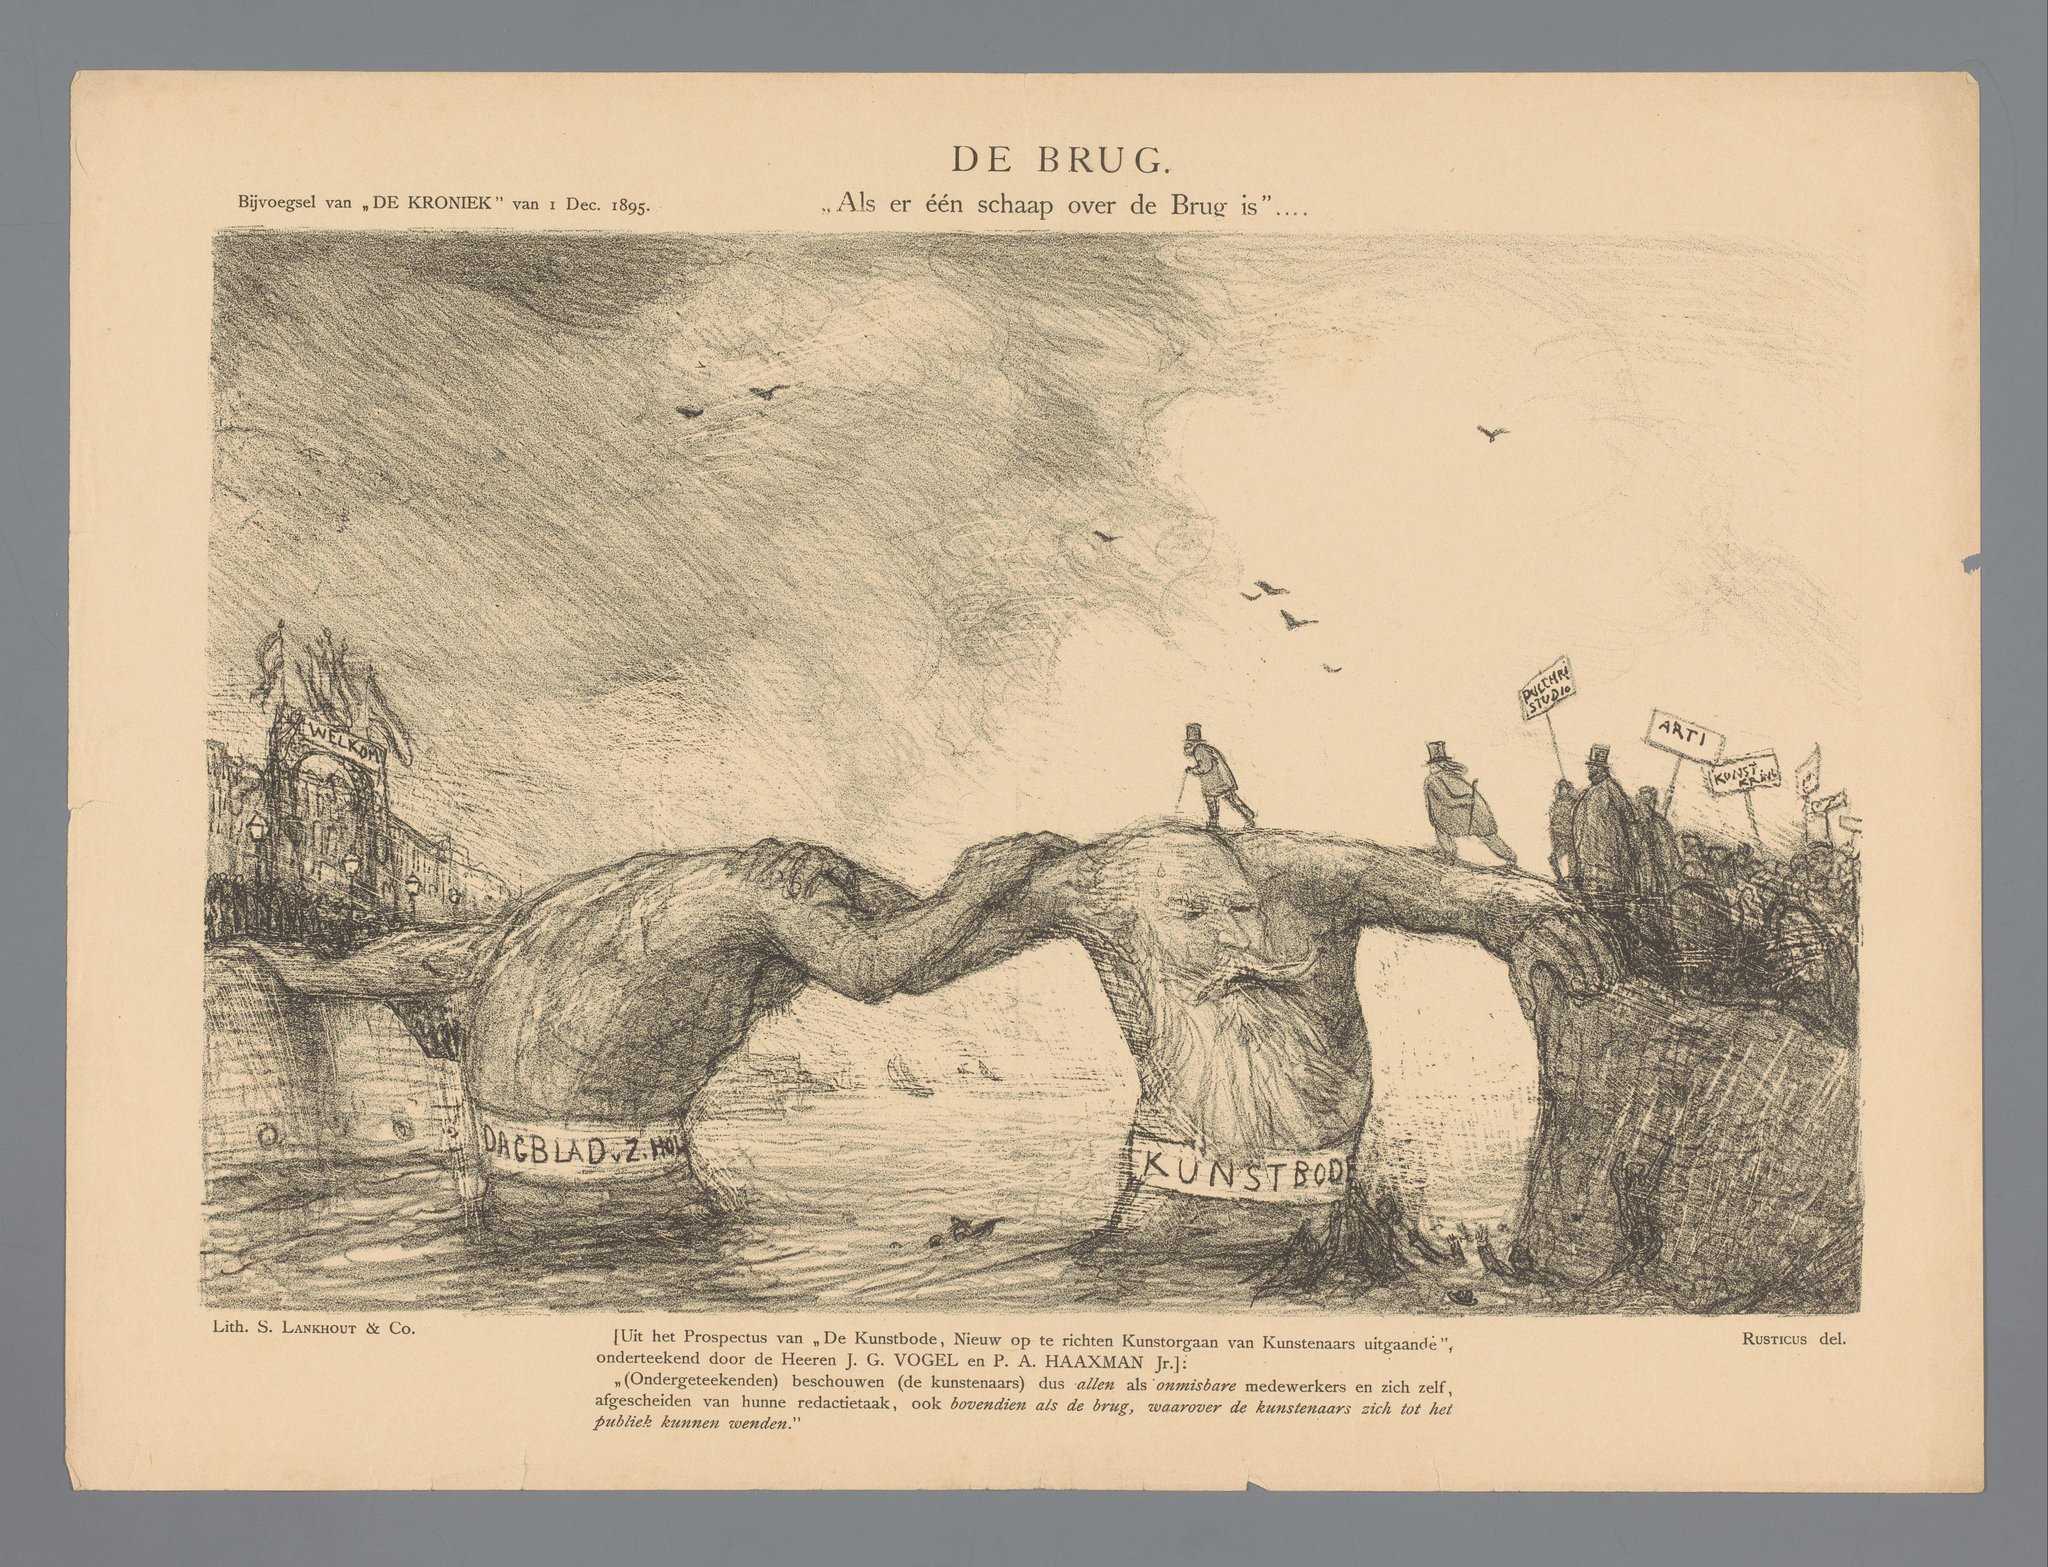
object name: cartoon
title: De Brug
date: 1895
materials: paper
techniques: lithograph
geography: the hague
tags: painter, print maker, draughtsman, johannes gijsbert vogel, circle, club of artists, bridge, netherlands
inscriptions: date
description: Spotprent op de plannen voor de oprichting van het tijdschrift De Kunstbode, door J.G. Vogel en P.A. Haaxman jr. De Kunstbode en het Dagblad van Zuid-Holland vormen een brug waarover kunstenaars en kunstenaarssociëteiten het publiek kunnen bereiken. Onderaan een citaat uit de prospectus voor het blad. Verschenen in de bijvoegsel van 'De Kroniek' van 1 december 1895.